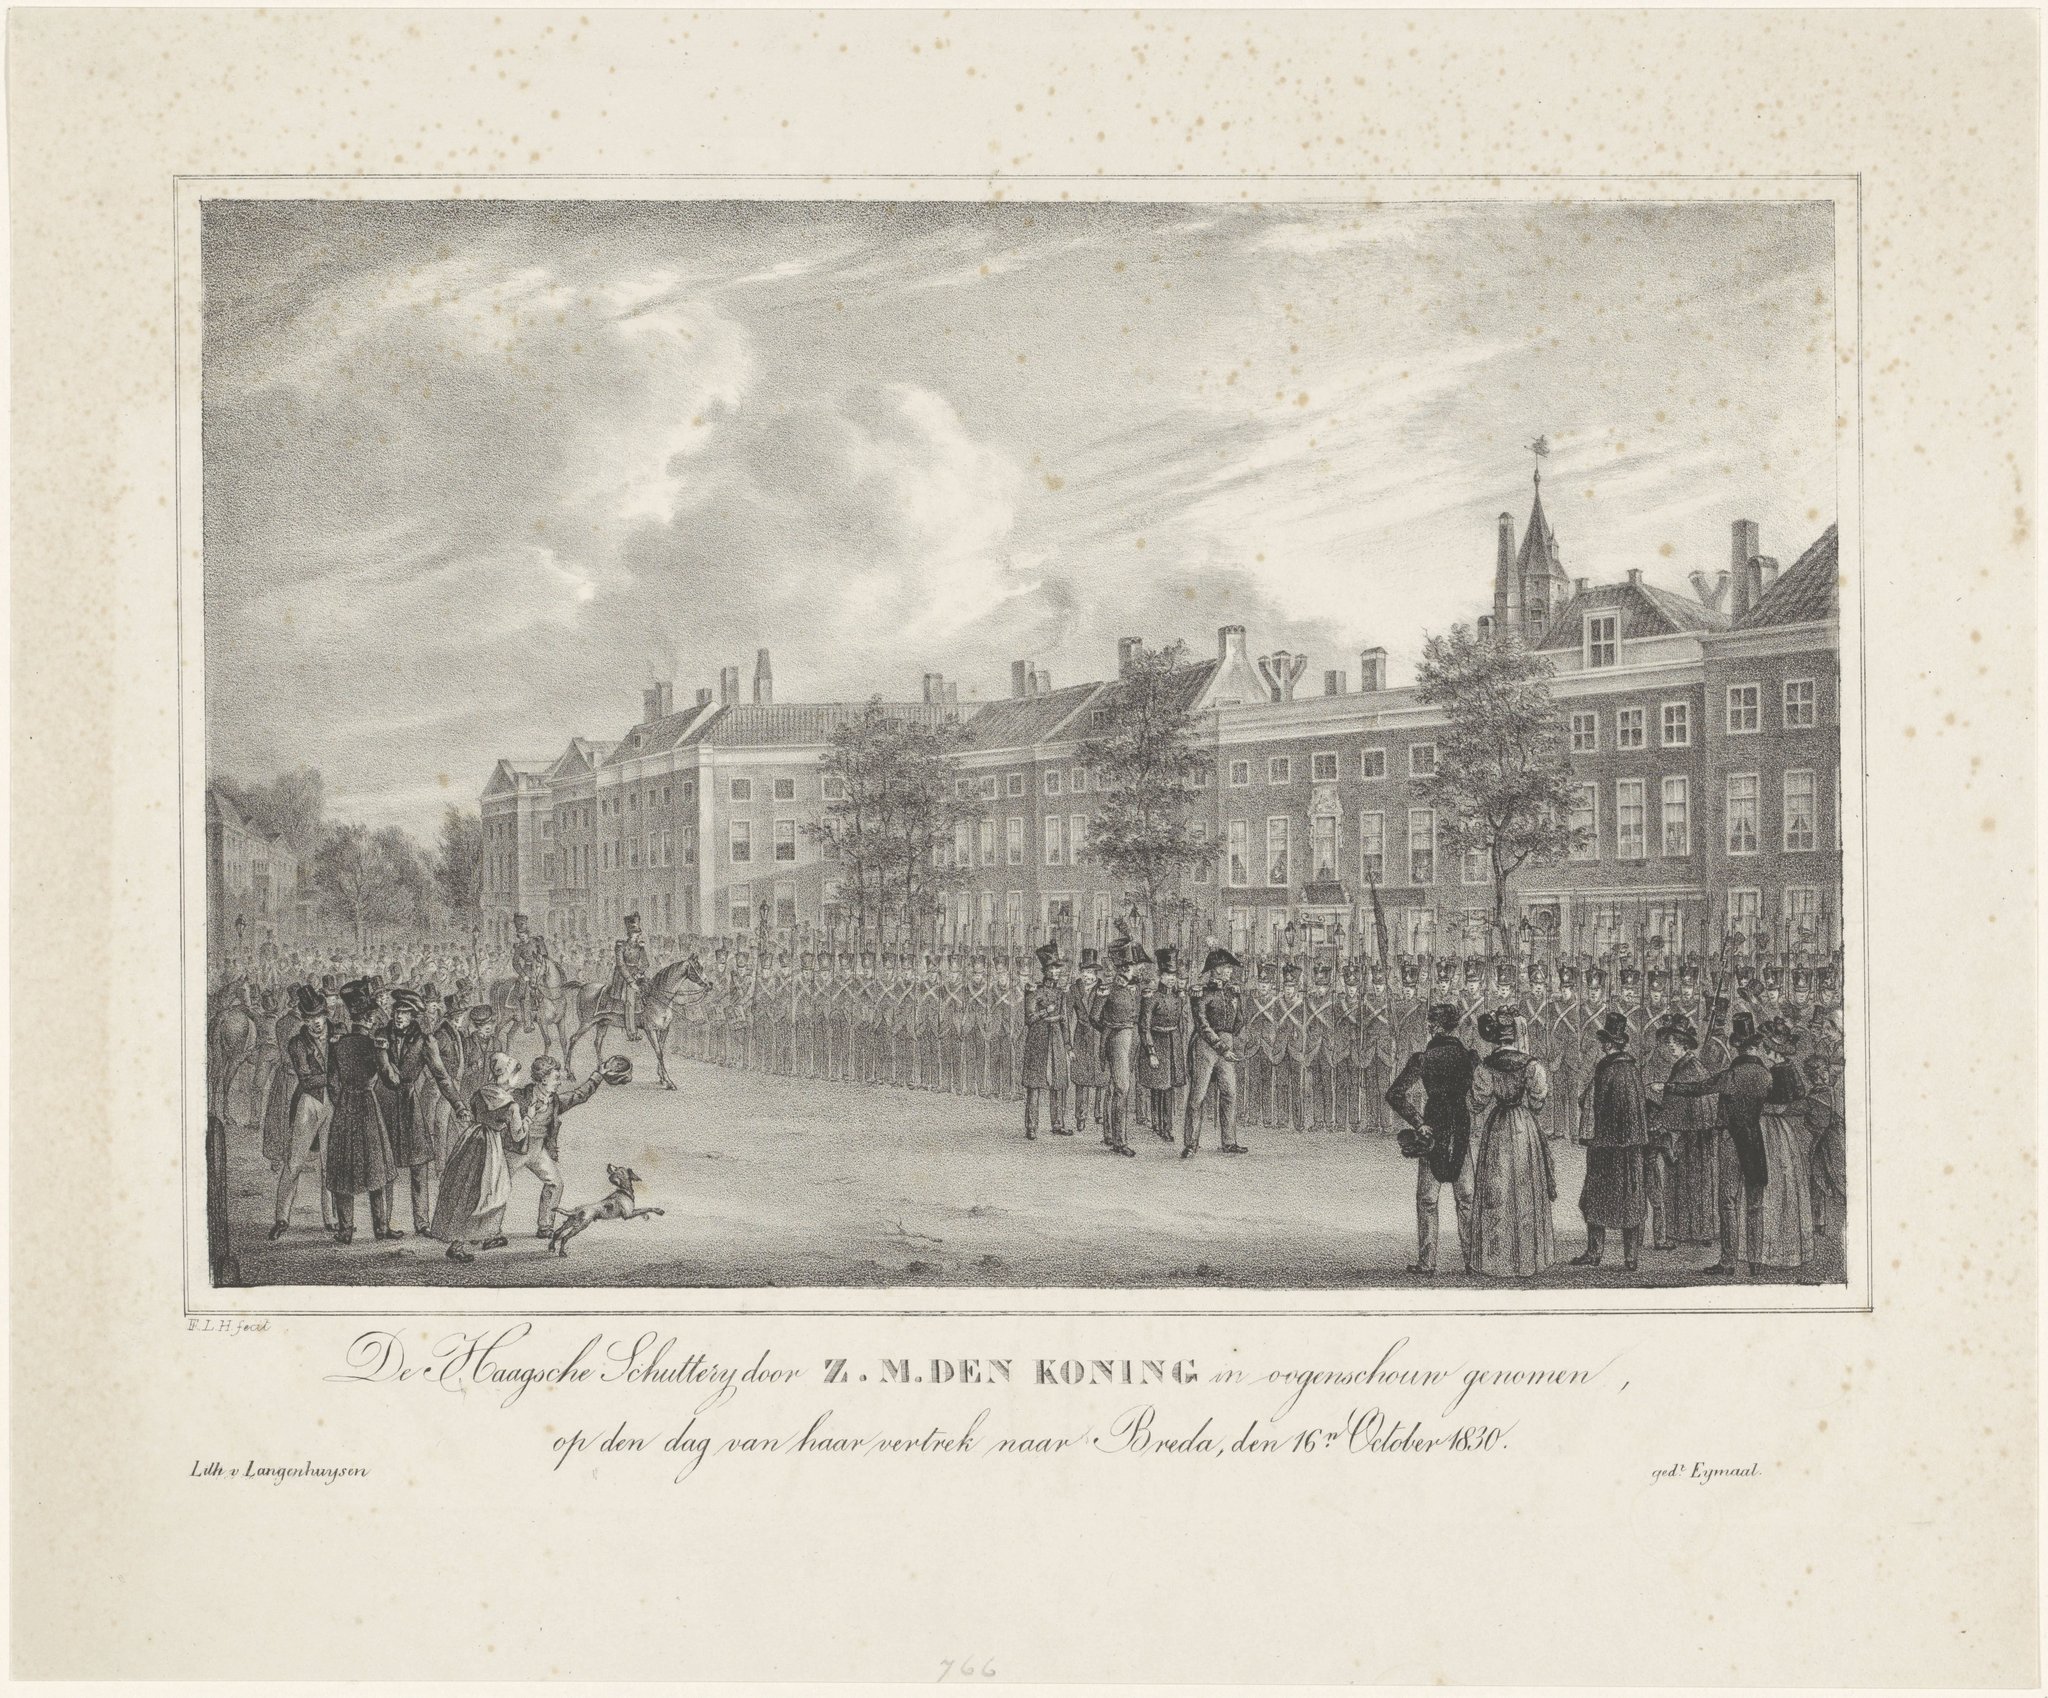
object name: print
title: Inspectie van de Haagsche Schutterij door de koning, 1830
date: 1830-1831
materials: paper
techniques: lithograph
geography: netherlands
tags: the hague, berlin, william i of the netherlands, review, inspection (of company, unit, troop), leave-taking (of soldiers)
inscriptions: collector's mark:, collector's mark: Lugt 2228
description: Inspectie van de manschappen van de vrijwillige Haagsche Schutterij door de koning Willem I, 16 oktober 1830. De troepen maken zich gereed om naar Breda te vertrekken.